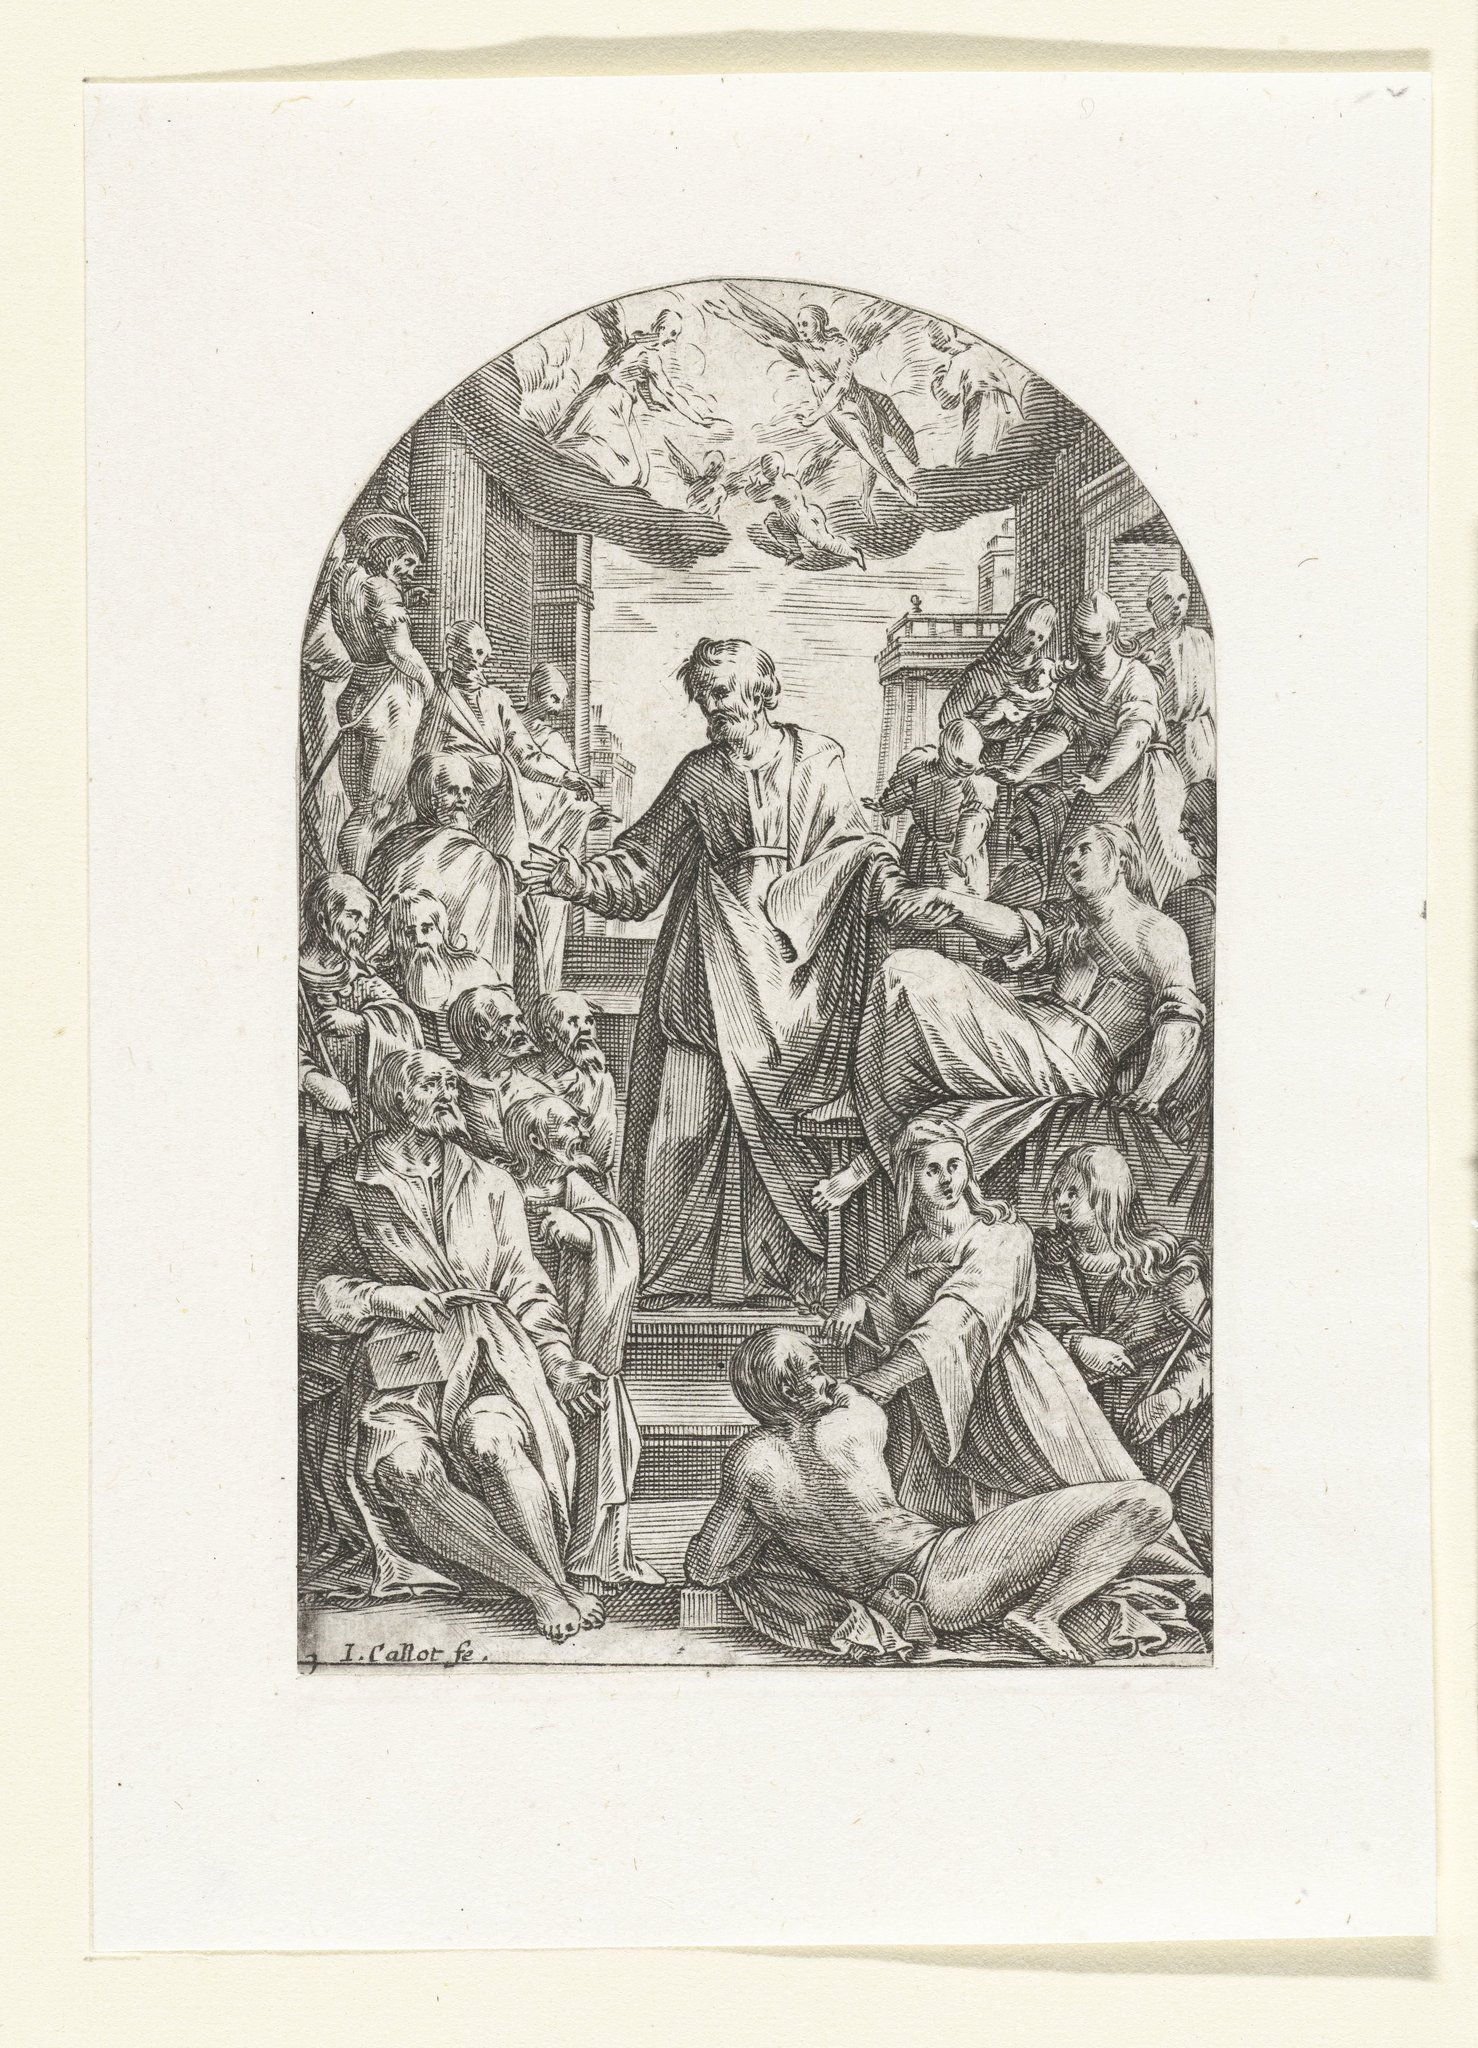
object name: print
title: Schilderijen en sculpturen te Rome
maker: jacques callot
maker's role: draughtsman, print maker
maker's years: 1592-1635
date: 1608-1611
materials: paper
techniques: engraving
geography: rome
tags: tabitha is raised from the dead by peter's prayer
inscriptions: collector's mark: Lugt 240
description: In aanwezigheid van een groep belangstellenden pakt Petrus Tabitha's hand, waarop zij uit de dood opstaat. Deze prent is onderdeel van een serie van 29 voorstellingen van schilderijen en sculpturen in kerken te Rome, genummerd 1-16 en 1-13. (De eerste staat van deze serie, waarin de prenten ongenummerd zijn, behelst ook een titelprent).